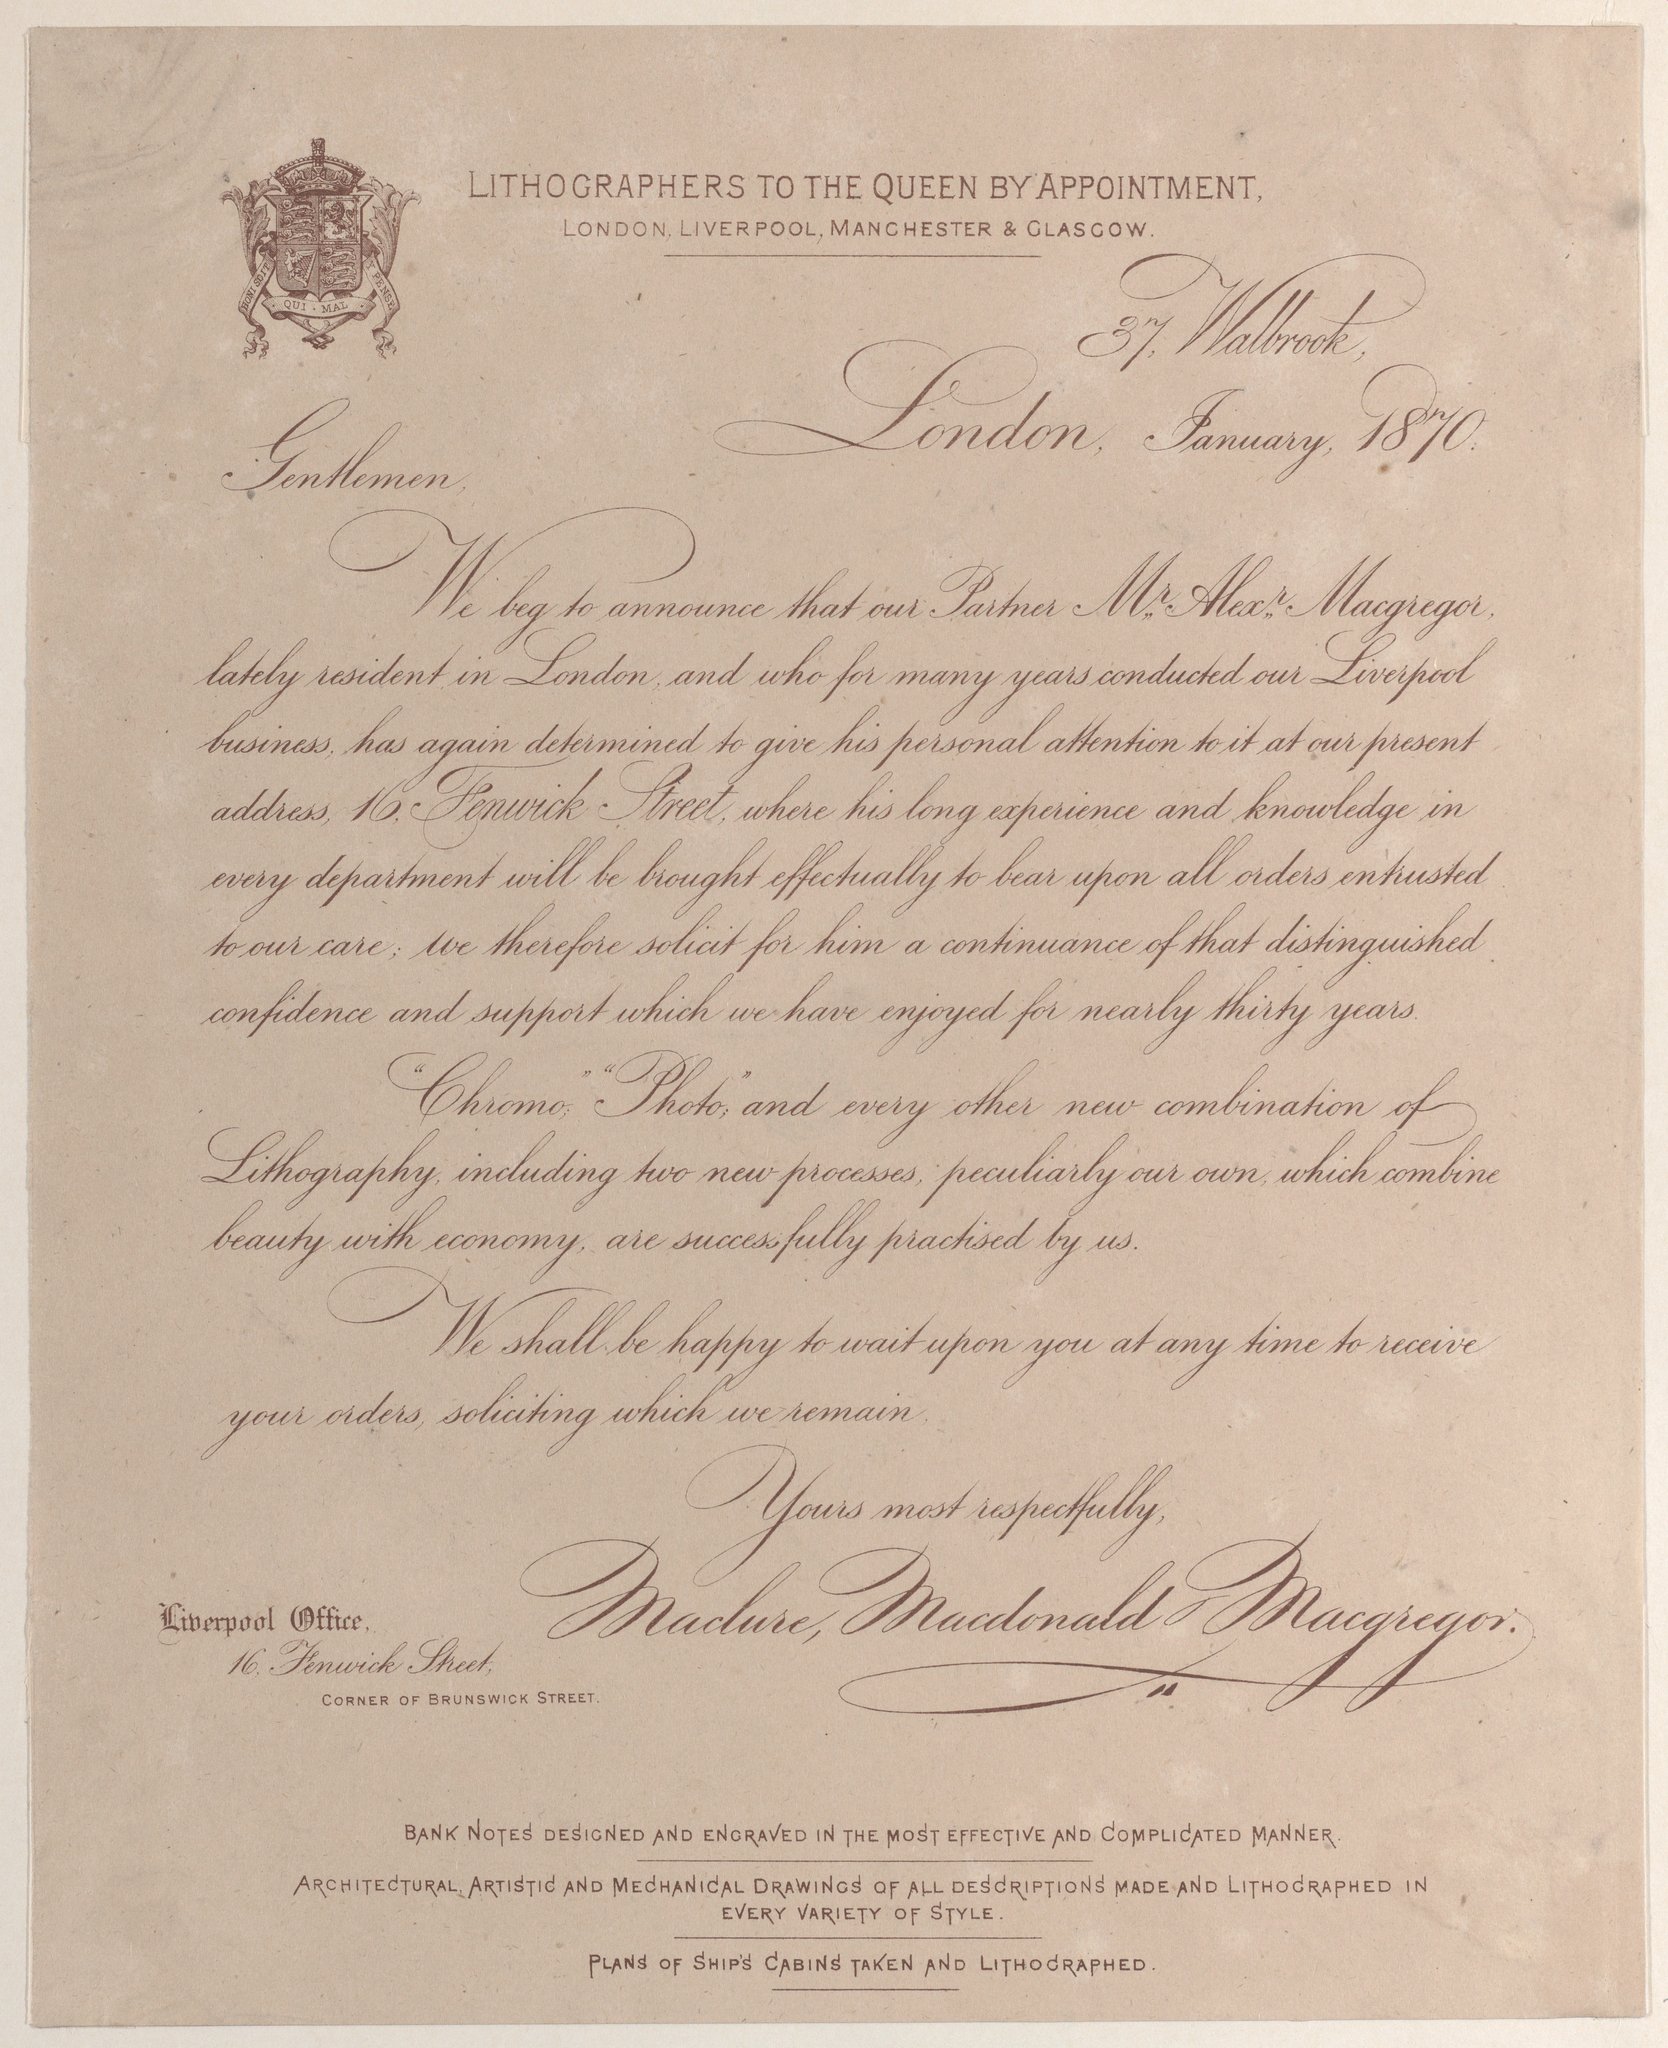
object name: print, trade card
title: Trade card for Maclure, Macdonald & Macgregor, publisher and printer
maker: anonymous, british, 19th century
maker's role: artist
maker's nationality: british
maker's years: 1800-1900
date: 1801-1900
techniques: lithography